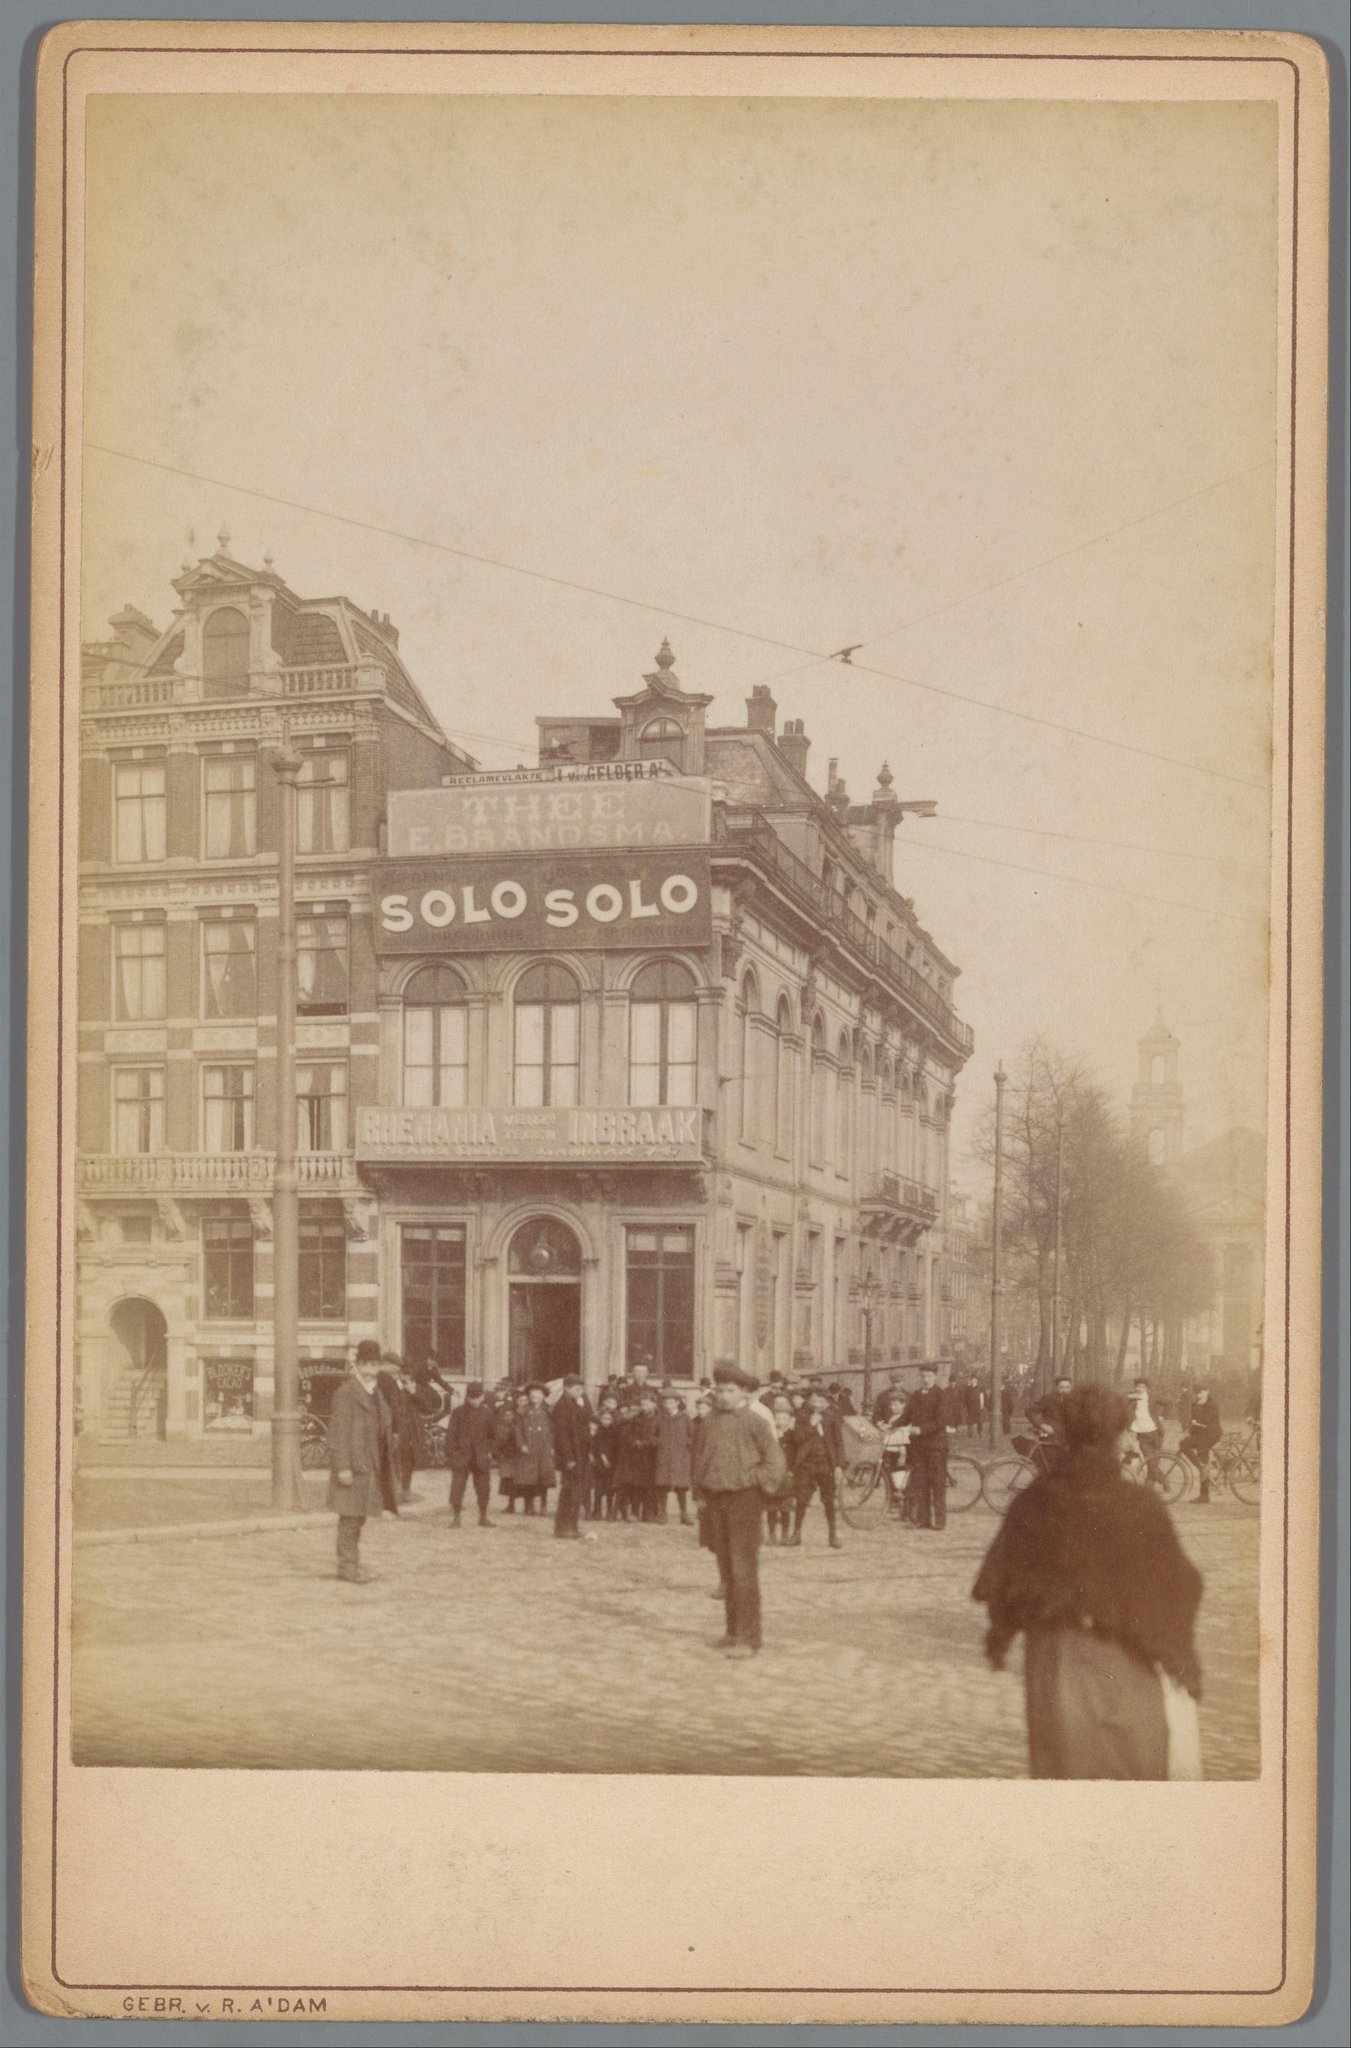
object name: cabinet photograph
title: Gezicht op het gebouw Casino met daarin de diamantbeurs aan het Waterlooplein in Amsterdam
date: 1860-1880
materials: cardboard, photographic support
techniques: albumen print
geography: amsterdam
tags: square, place, circus, etc.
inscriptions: number: ‘435’, inscription: ‘Het gebouw Casino Diamantbeurs aan het Waterlooplein.’, name: ‘Vosmaer’